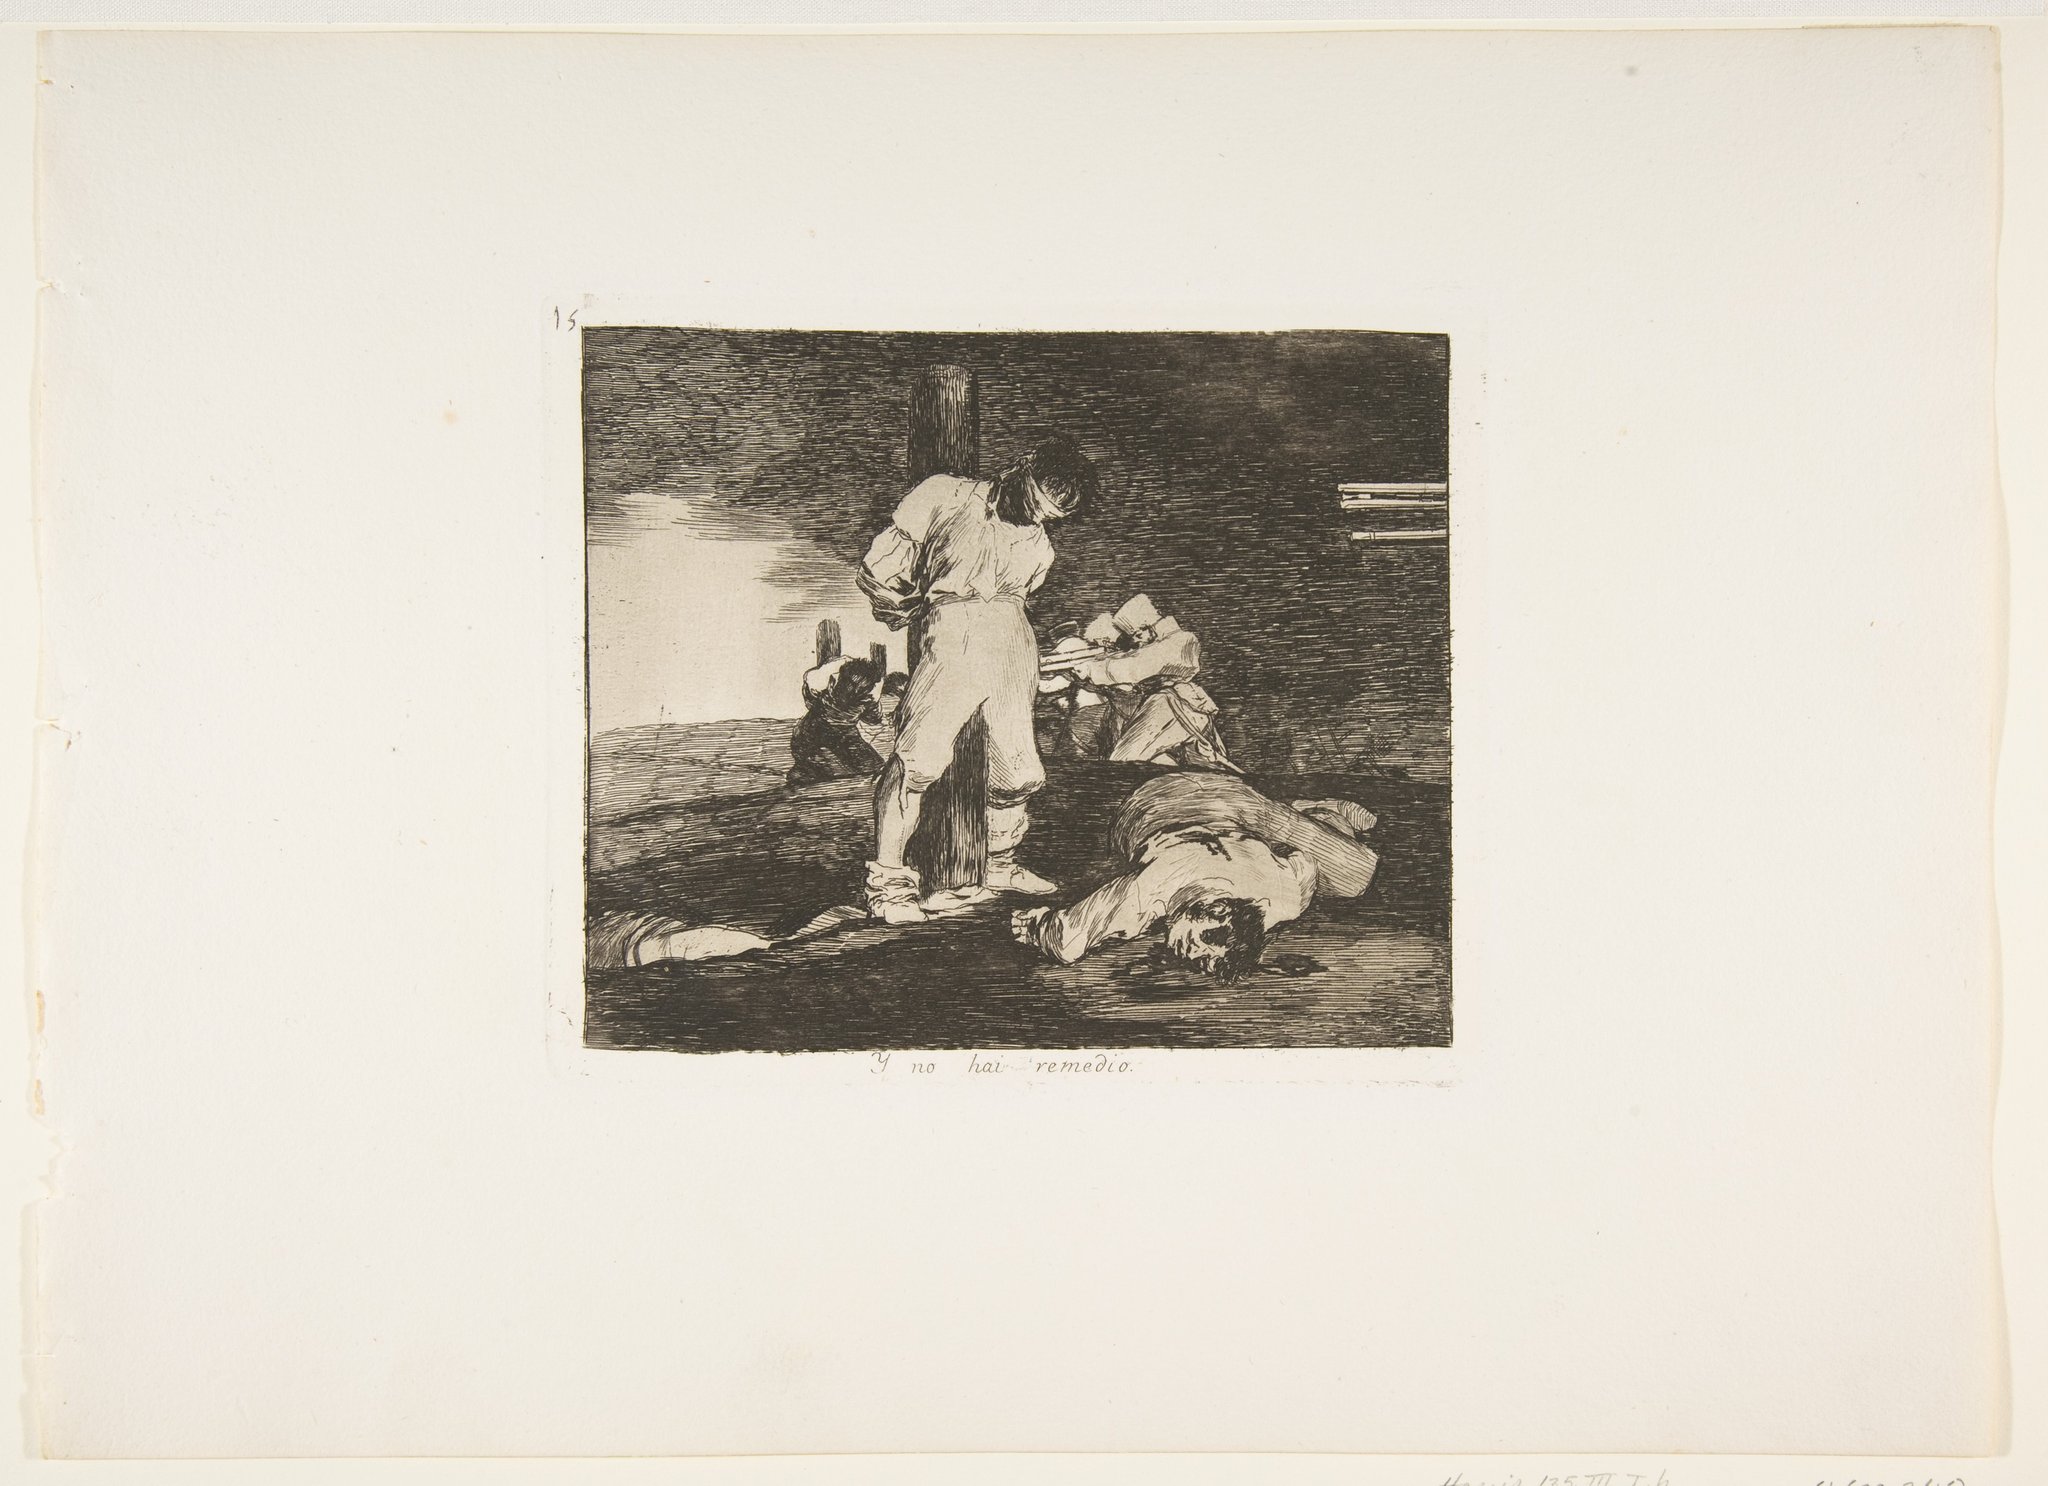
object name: print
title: Plate 15 from "The Disasters of War" (Los Desastres de la Guerra): And there is nothing to be done (Y no hai remedio)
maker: goya (francisco de goya y lucientes)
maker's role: artist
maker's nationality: spanish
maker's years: 1746-1828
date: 1810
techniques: engraving, drypoint, etching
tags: human figures,suffering,death